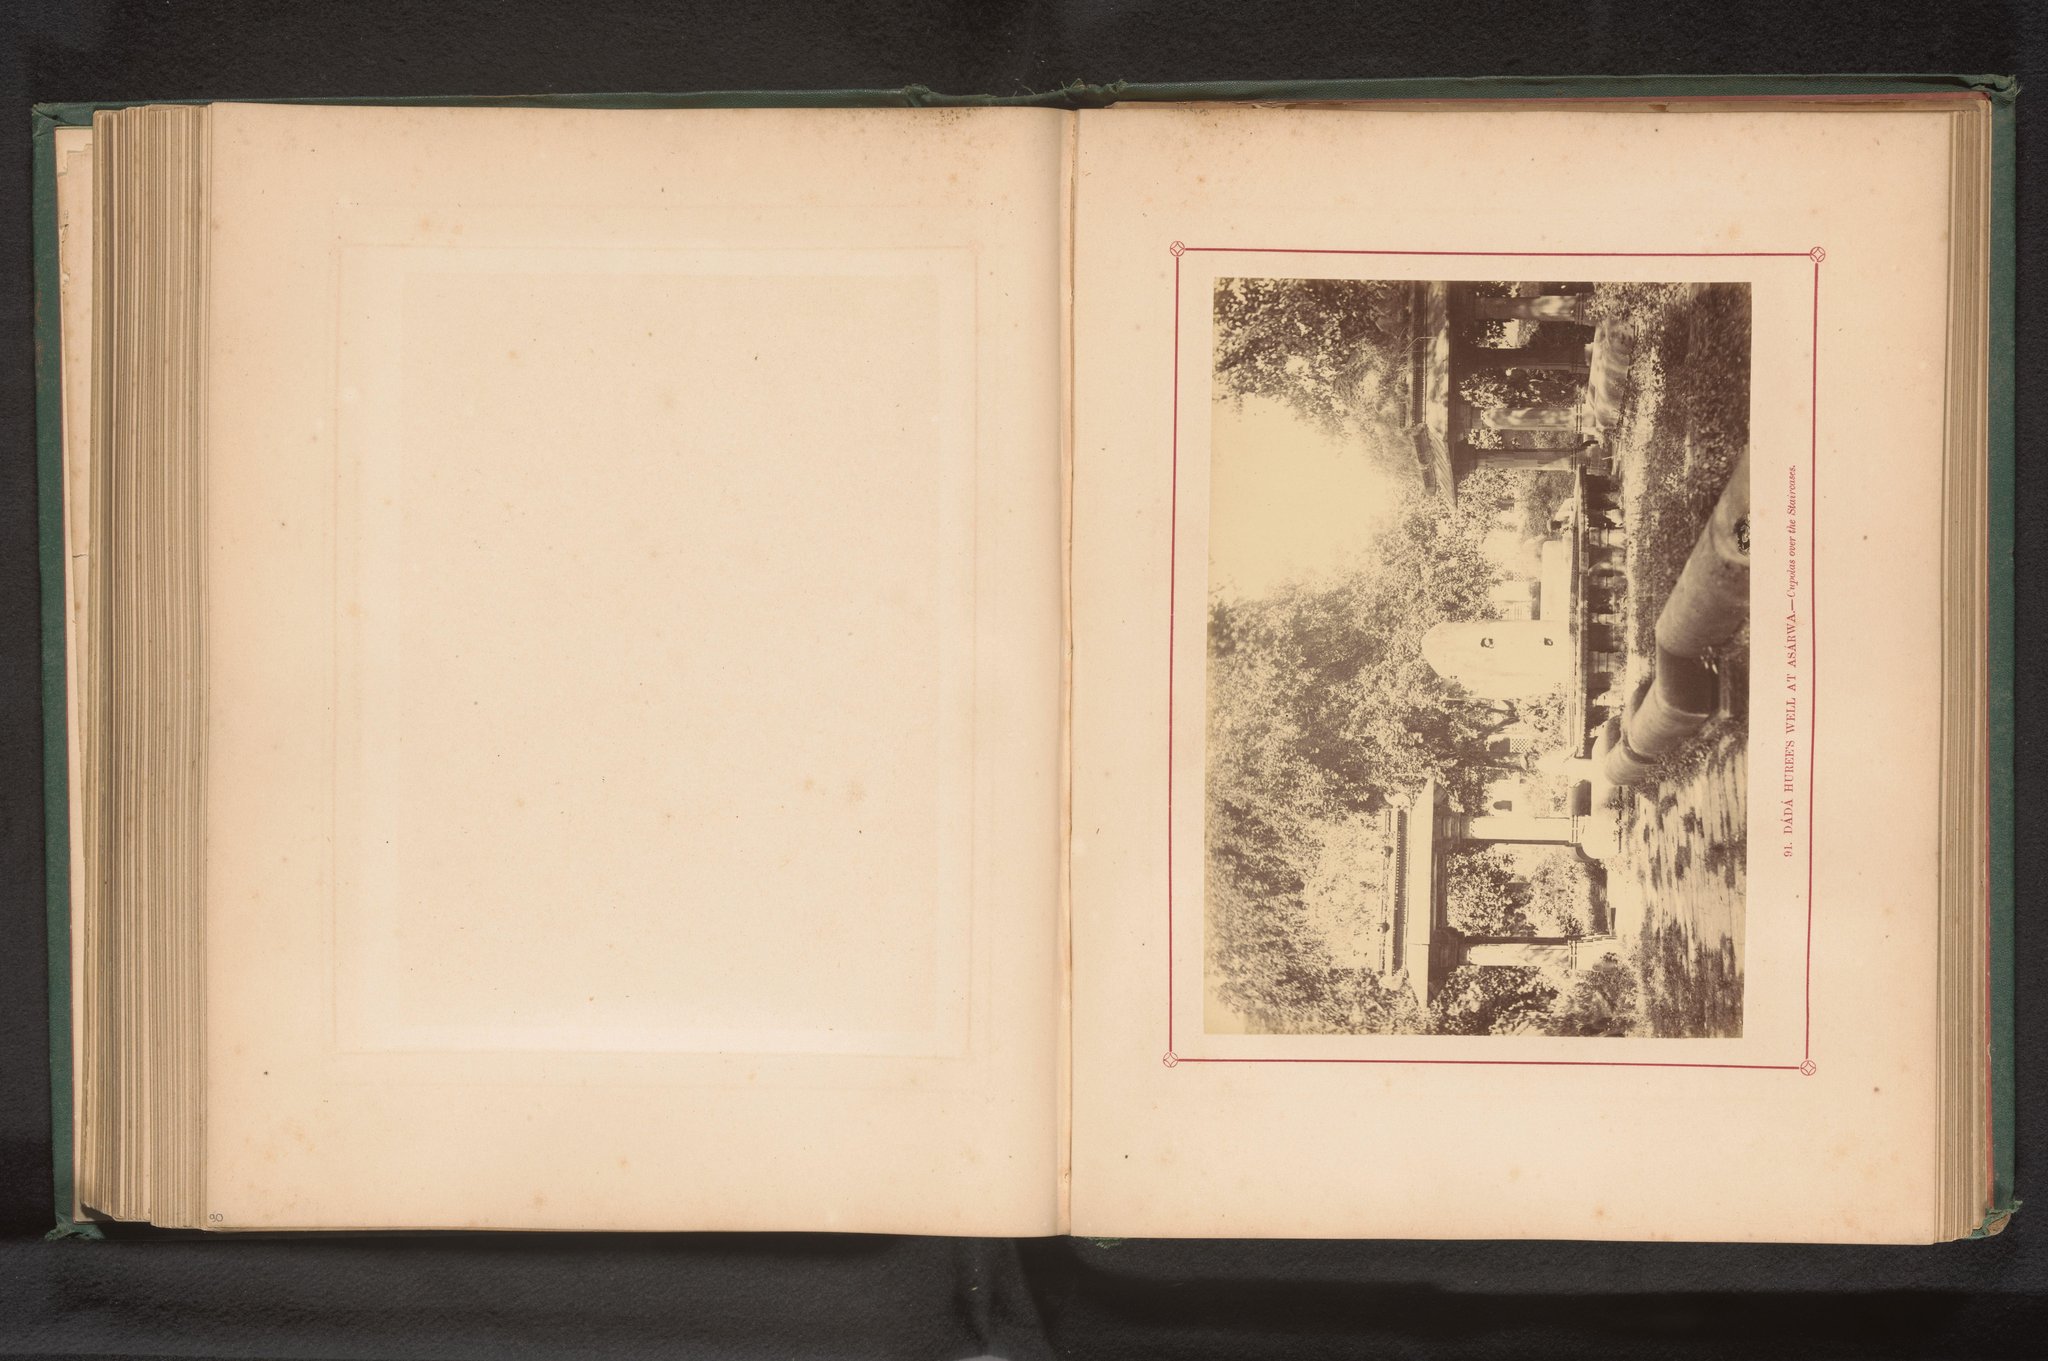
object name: photograph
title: Dádá Huree's well at Asárwa.- Cupolas over the Staircases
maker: thomas biggs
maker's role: fotograaf, kapitein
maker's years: 1822-1905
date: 1856-1866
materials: photographic support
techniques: albumen print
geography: ahmedabad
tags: well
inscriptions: number: ‘91.’